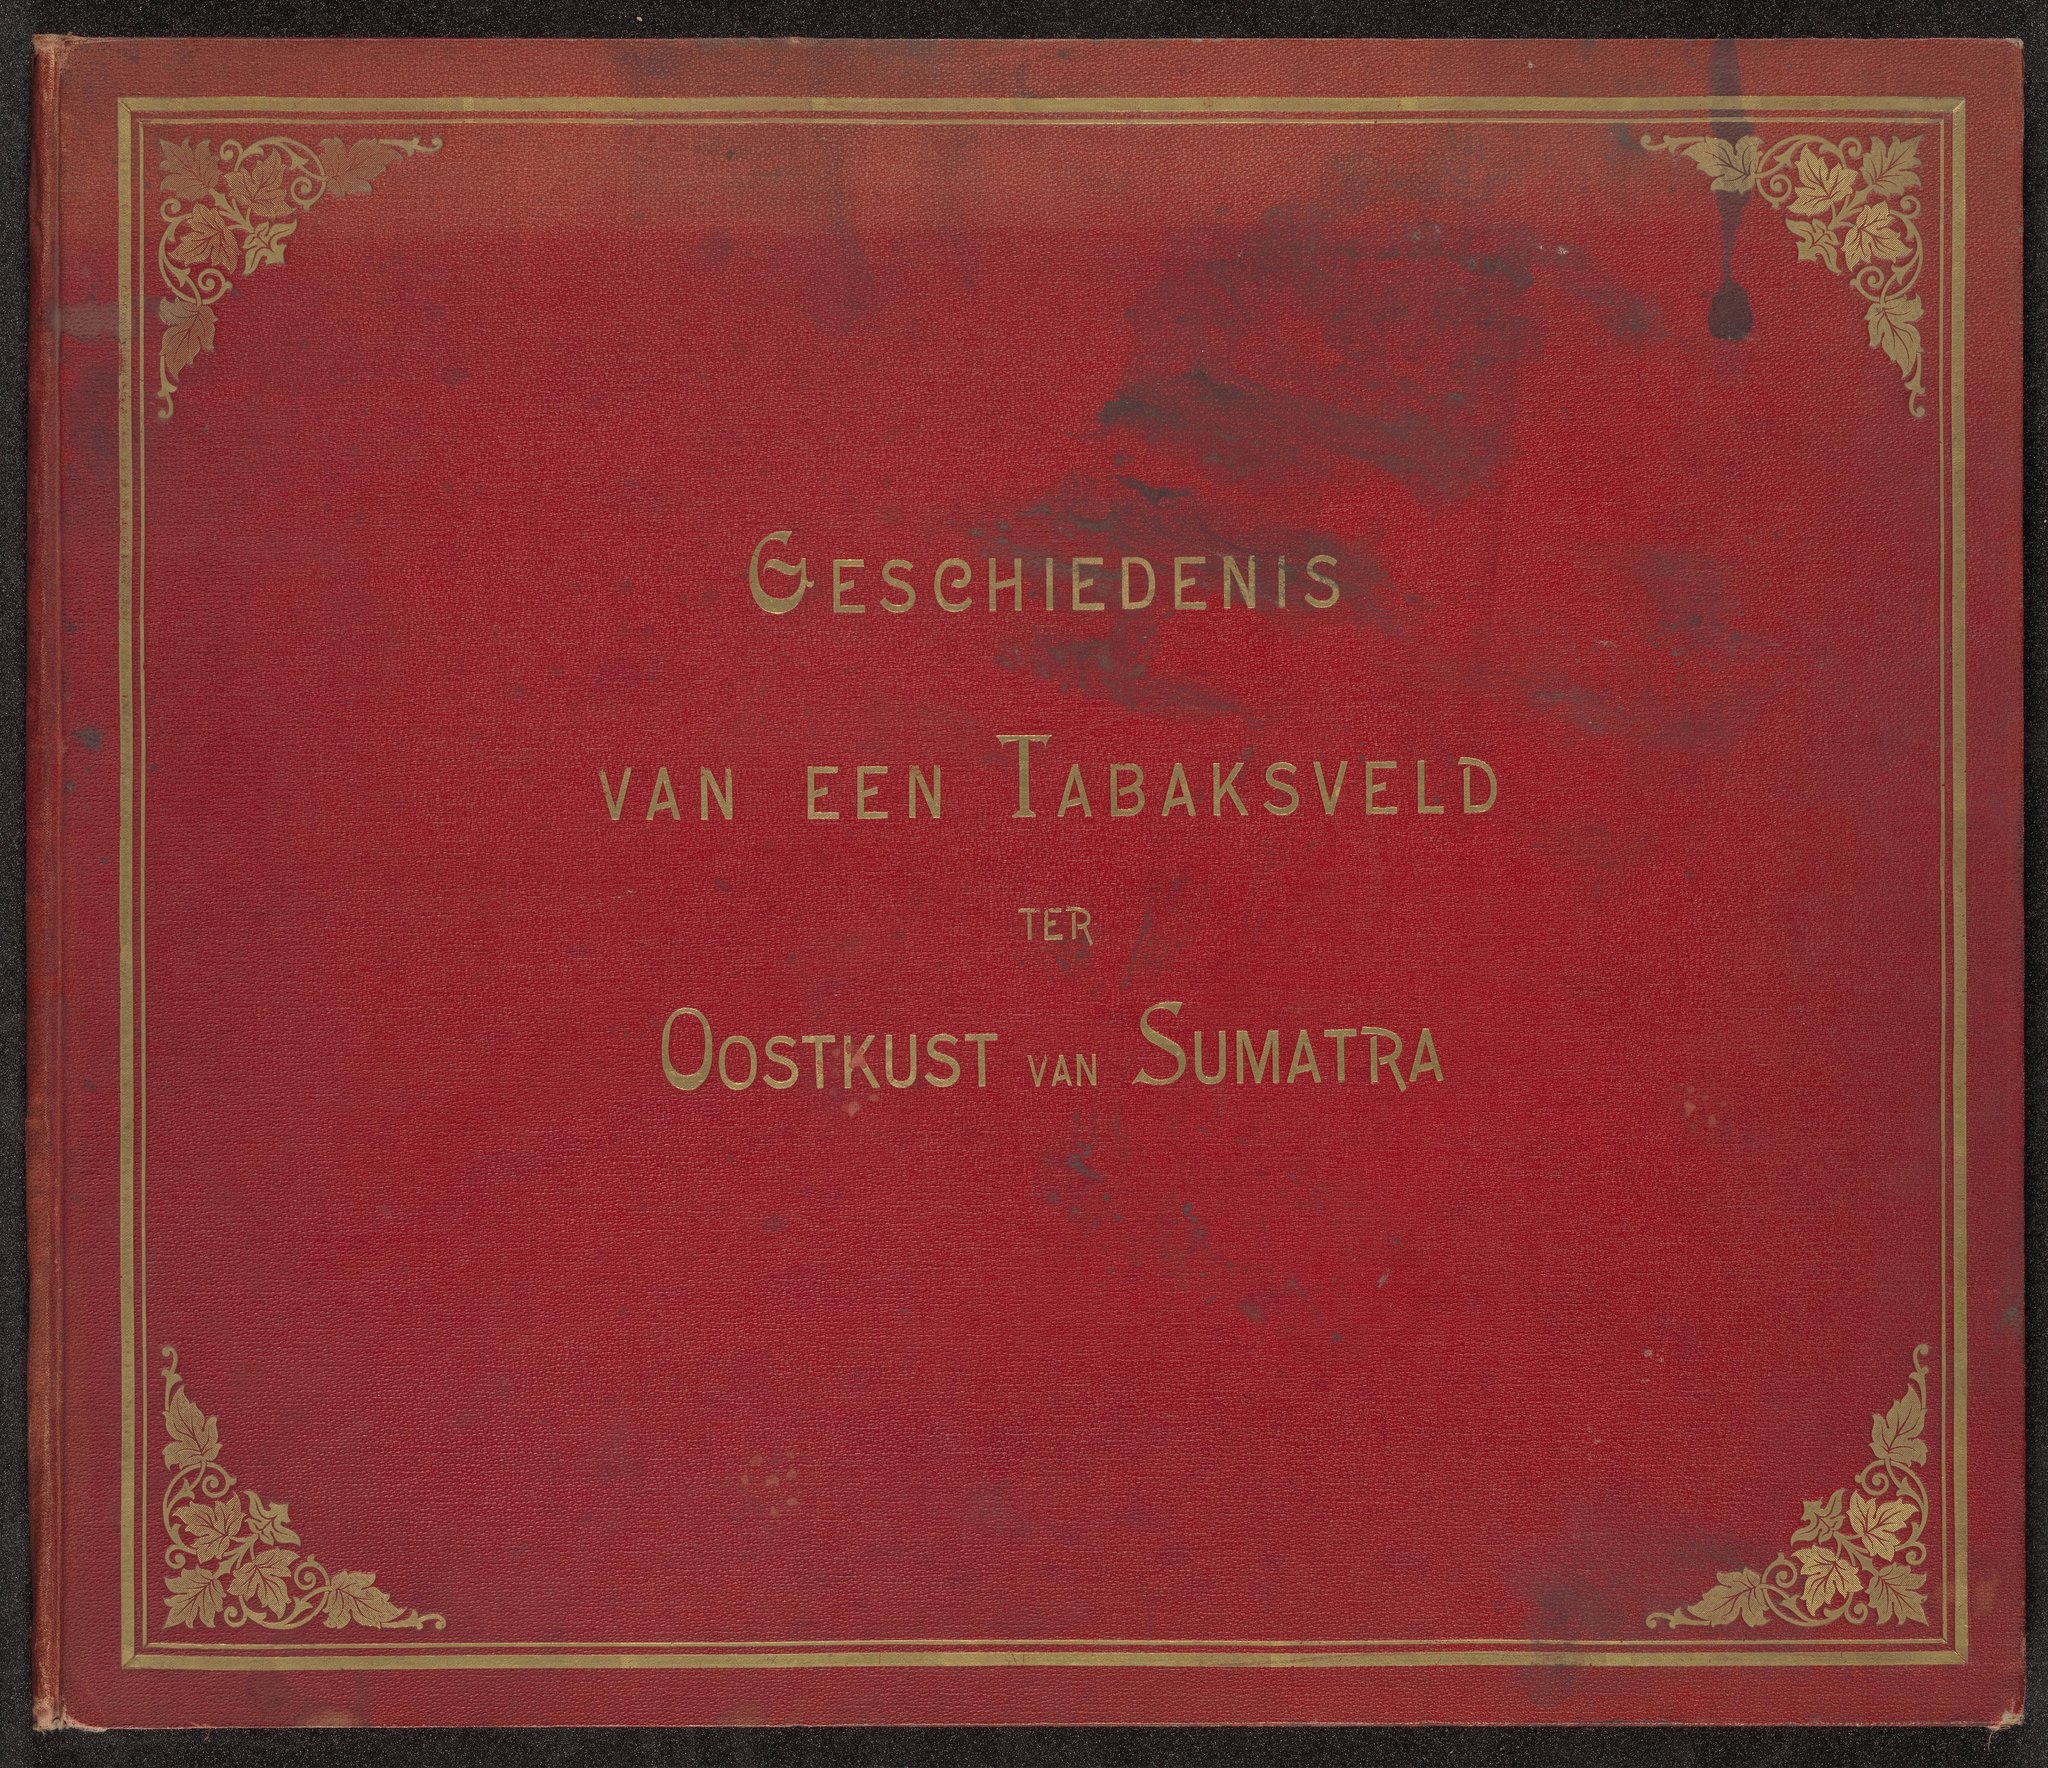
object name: portfolio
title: Fotoalbum van de aanleg van een tabaksveld op de oostkust van Sumatra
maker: Anonymous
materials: cardboard, linen, paper, photographic support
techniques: albumen print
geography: east sumatra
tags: plantation, tobacco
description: Rood portfolio voorzien van drie accoladevormige stofflappen met op de voorkant de titel in gouddruk. Voor- en achterplat zijn in de vier hoeken versierd met een bladmotief, eveneens in gouddruk. De schutbladen en stofflappen zijn beplakt met gegaufreerd papier. Het portfolio bevat zeven kartonnen bladen met evenveel foto's, die steeds vanuit hetzelfde camerastandpunt zijn gemaakt. Ze geven de opeenvolgende stadia weer van de aanleg van een tabaksplantage, op een onbekende plek aan de oostkust van Sumatra.